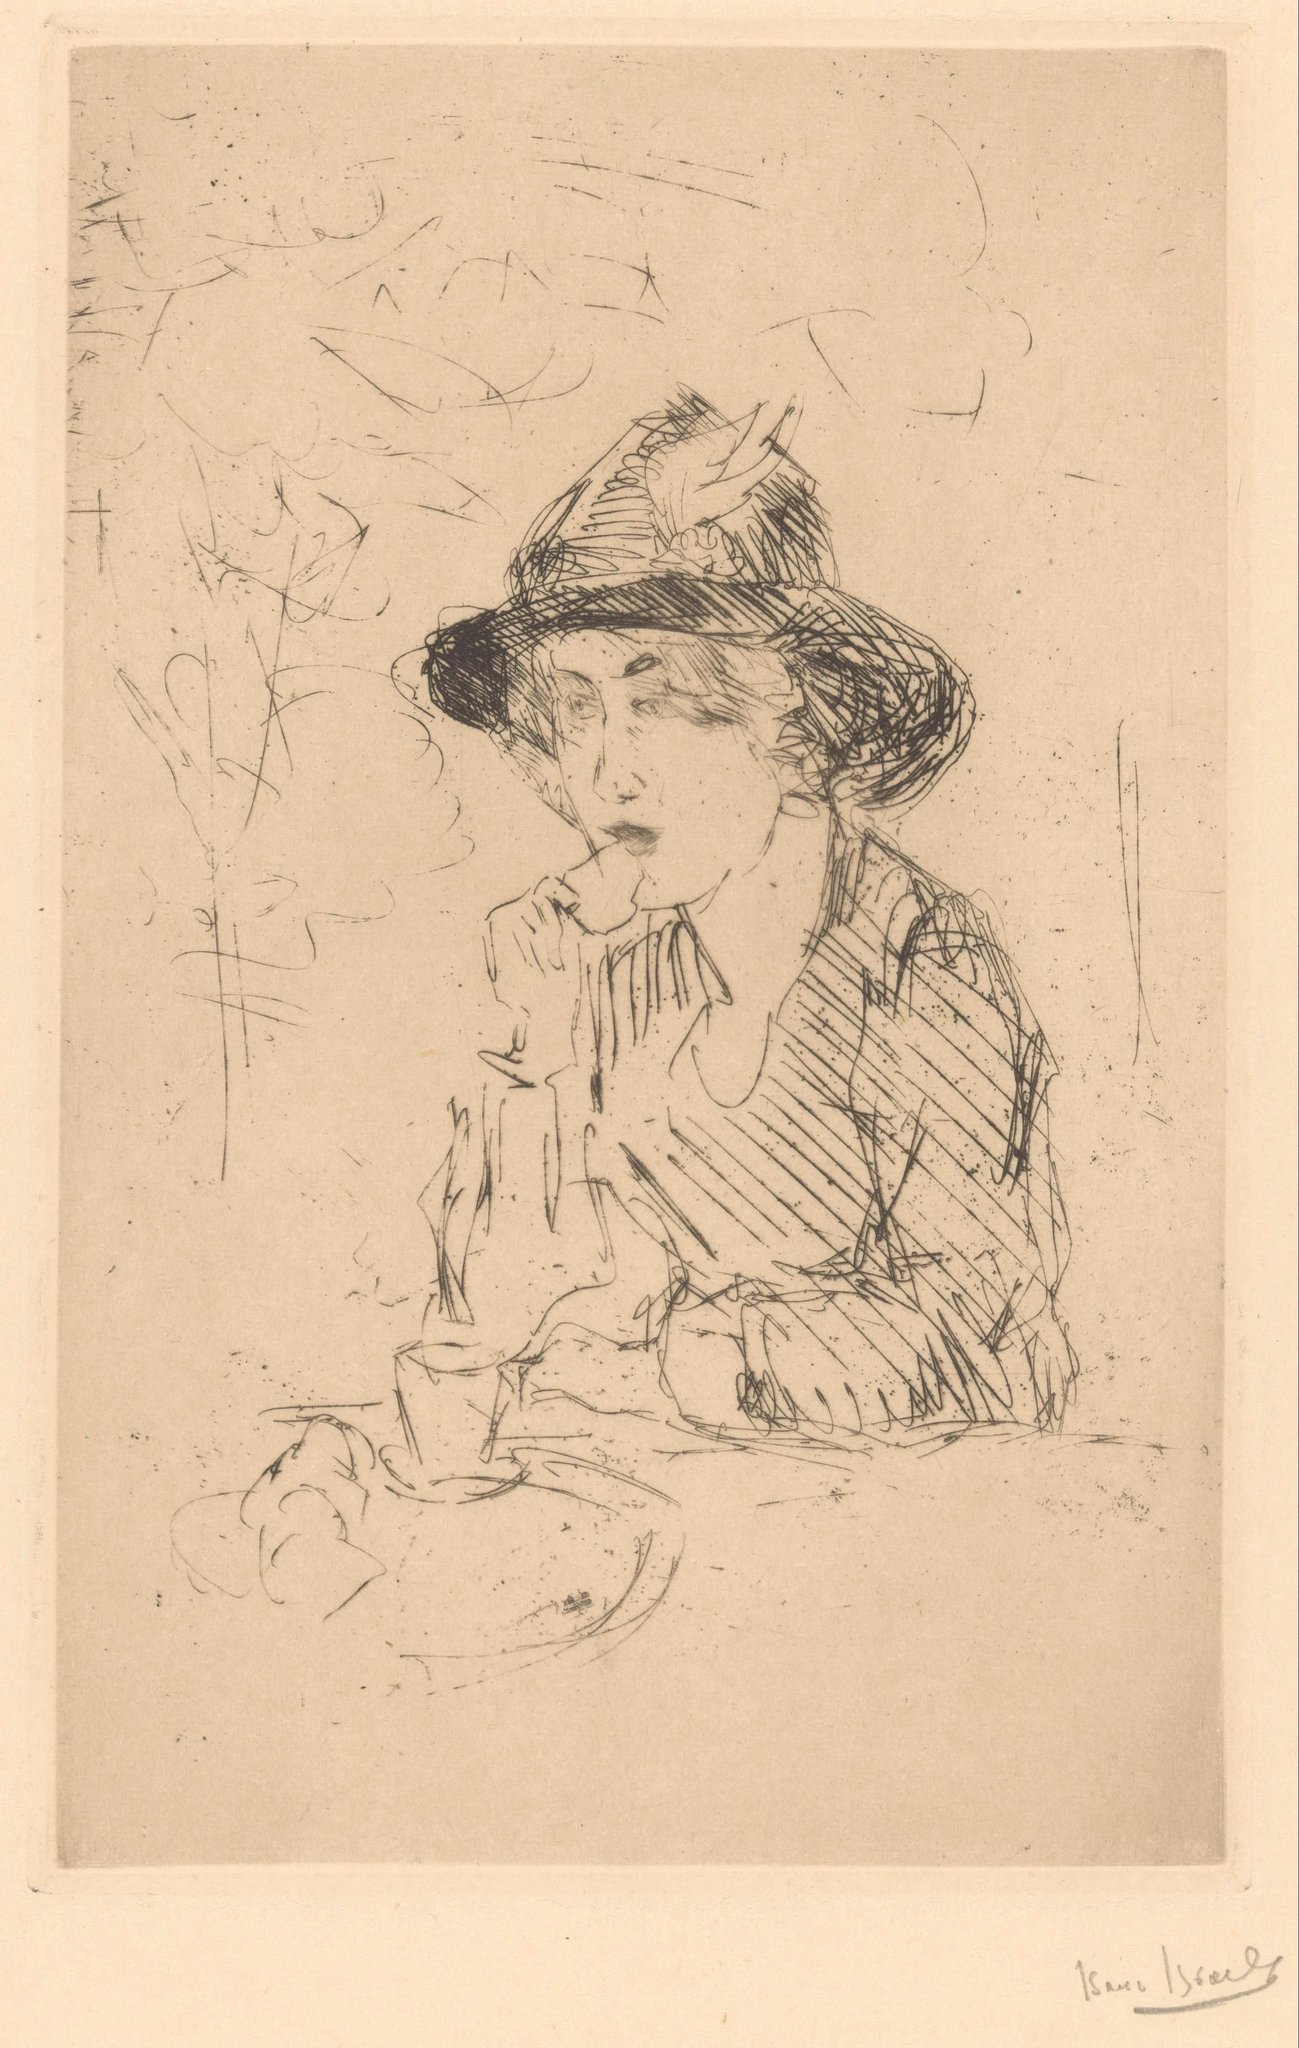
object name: print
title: Jonge vrouw met hoed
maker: isaac israels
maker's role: draughtsman, painter, print maker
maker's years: 1865-1934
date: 1878-1934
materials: paper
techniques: etching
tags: head-gear: hat, eating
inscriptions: collector's mark: Lugt 2228, collector's mark: Lugt 2760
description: De vrouw zit aan tafel; voor haar staat een kopje.